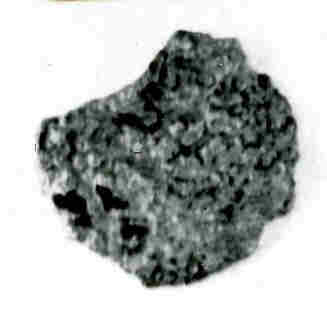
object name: coin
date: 401-1400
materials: copper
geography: iran